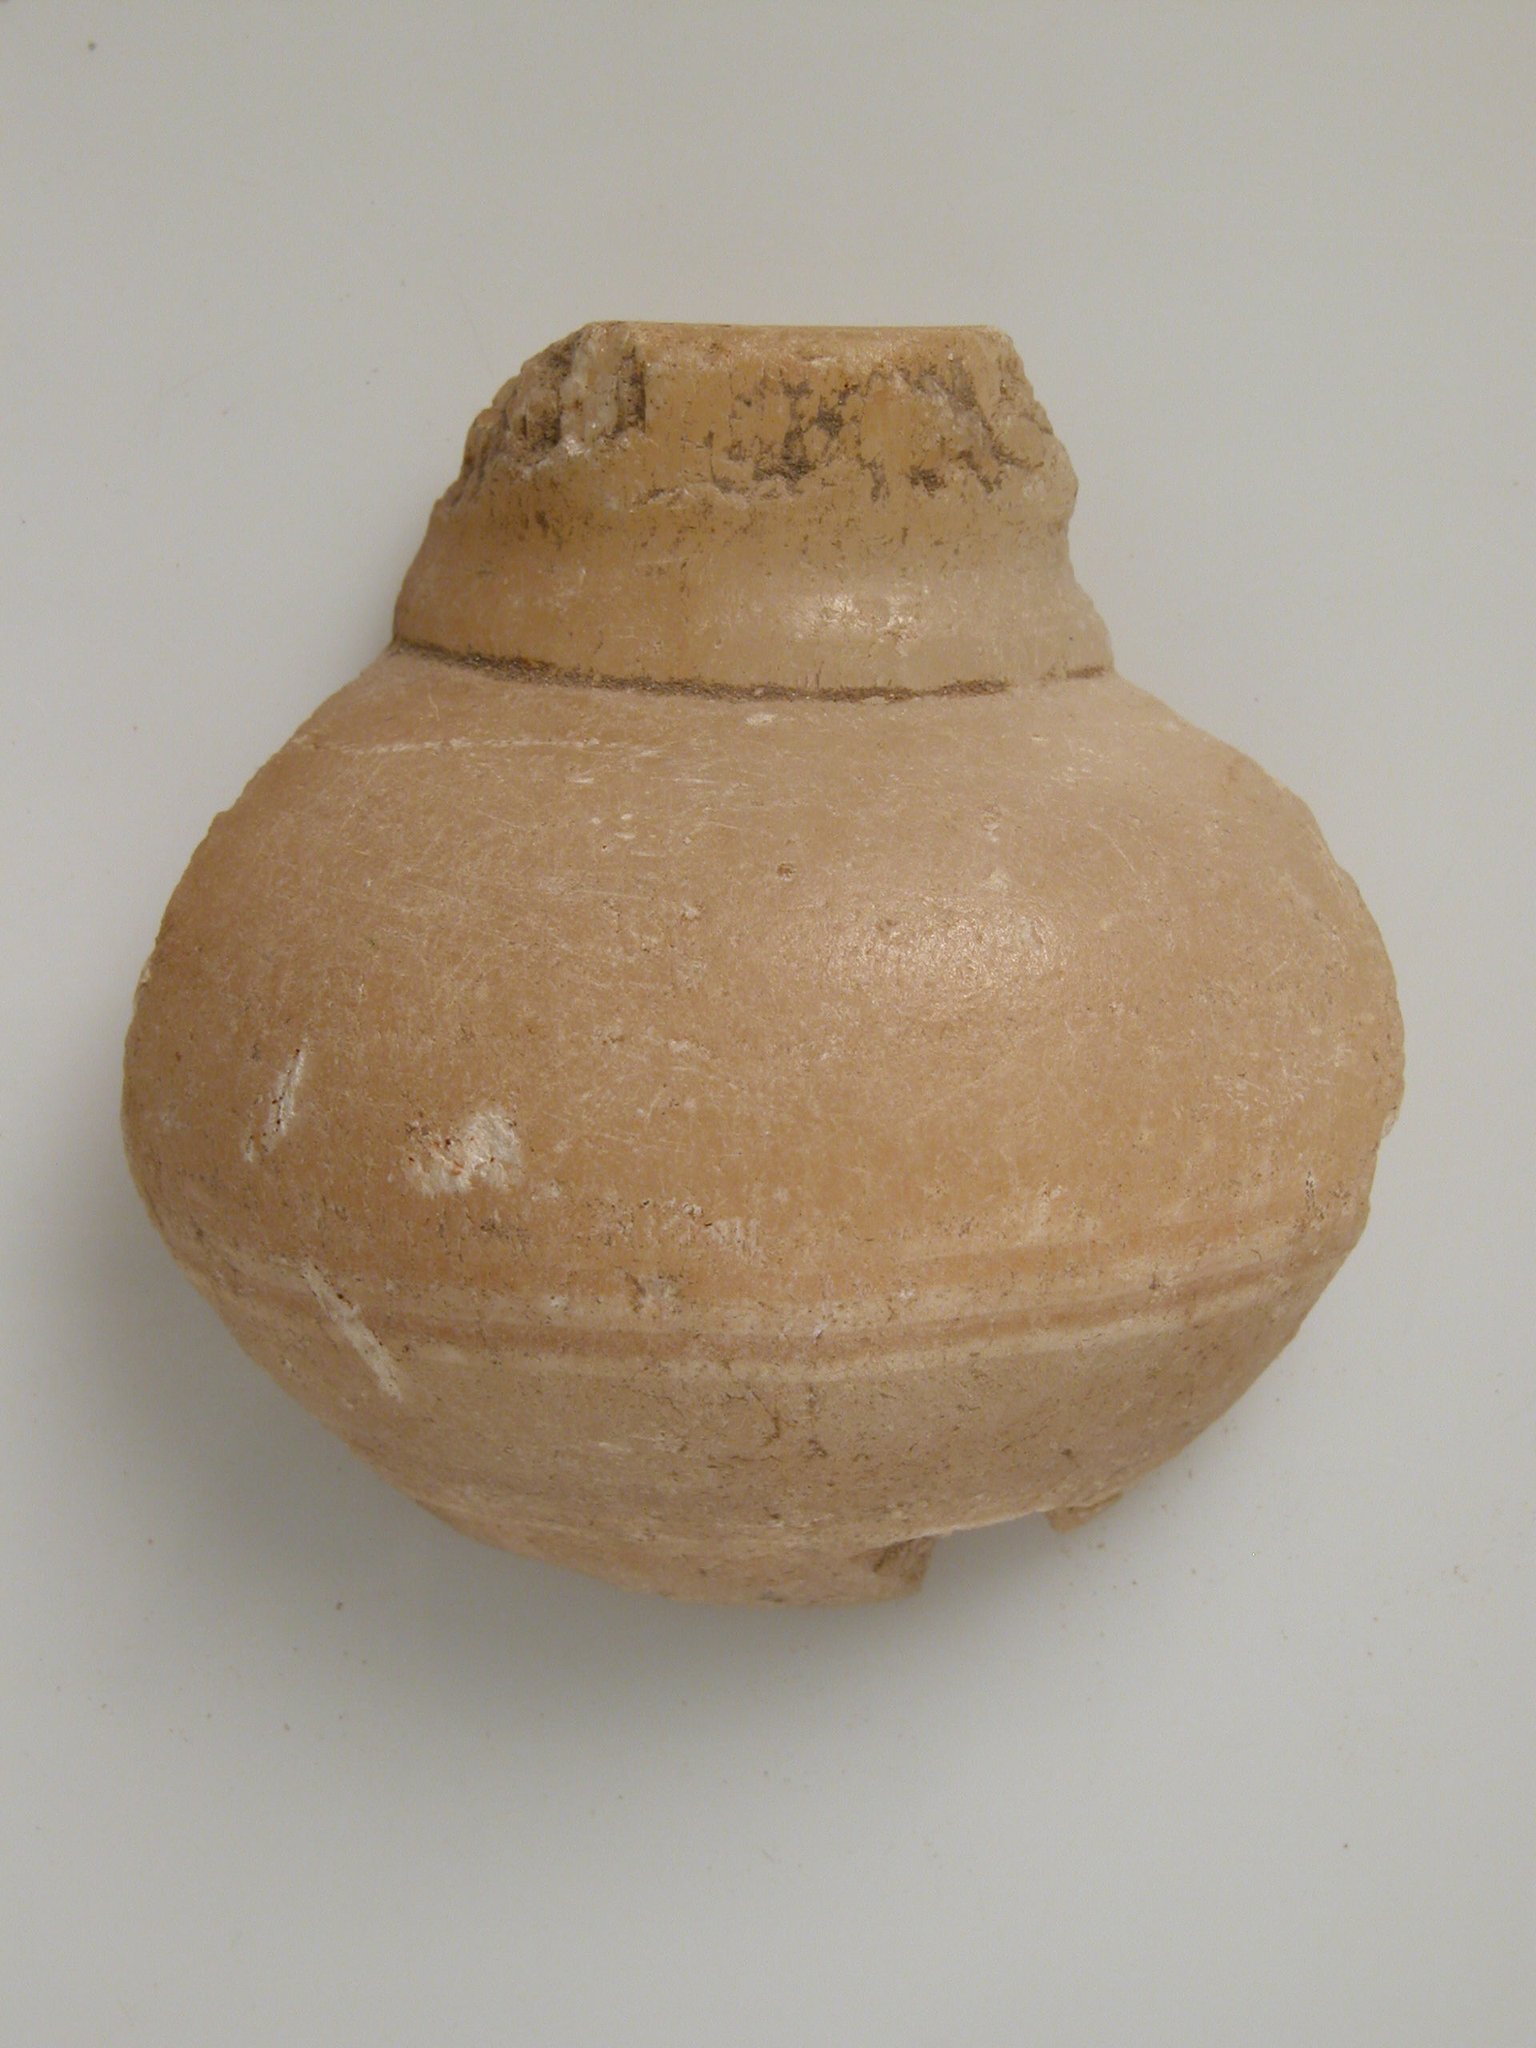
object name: vessel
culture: coptic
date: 301-700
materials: alabaster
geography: egypt